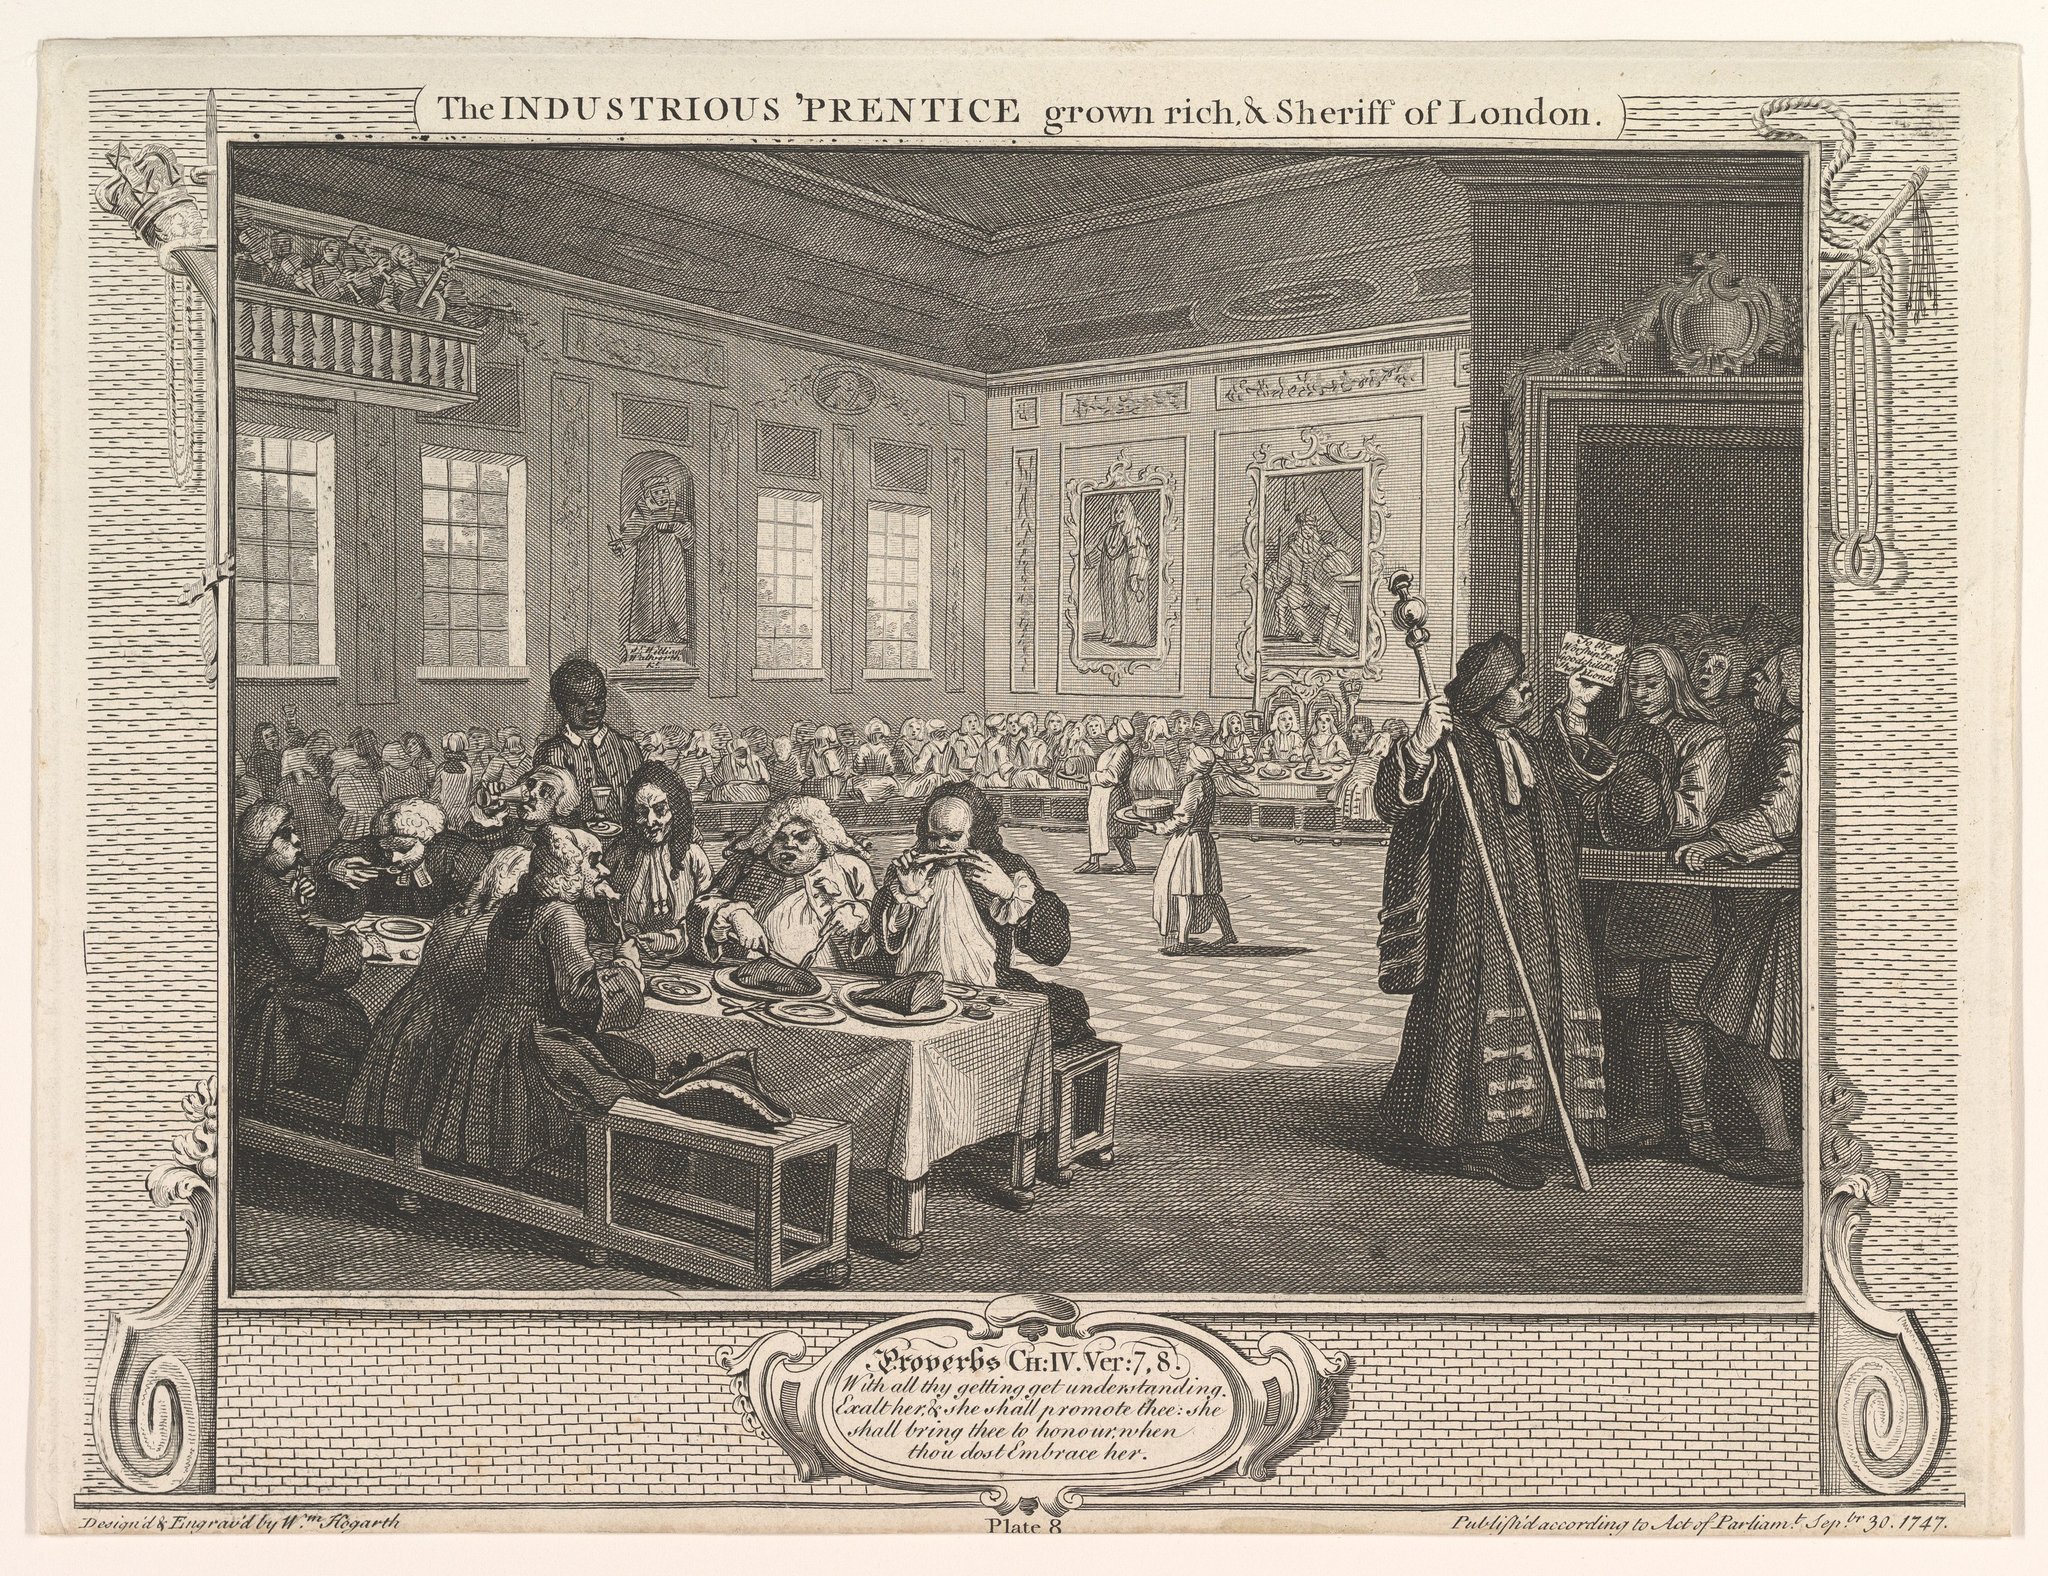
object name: print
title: The Industrious 'Prentice Grown Rich and Sheriff of London (Industry and Idleness, plate 8)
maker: william hogarth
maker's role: artist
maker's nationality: british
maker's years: 1697-1764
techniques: engraving, etching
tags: interiors,men,women,crowd